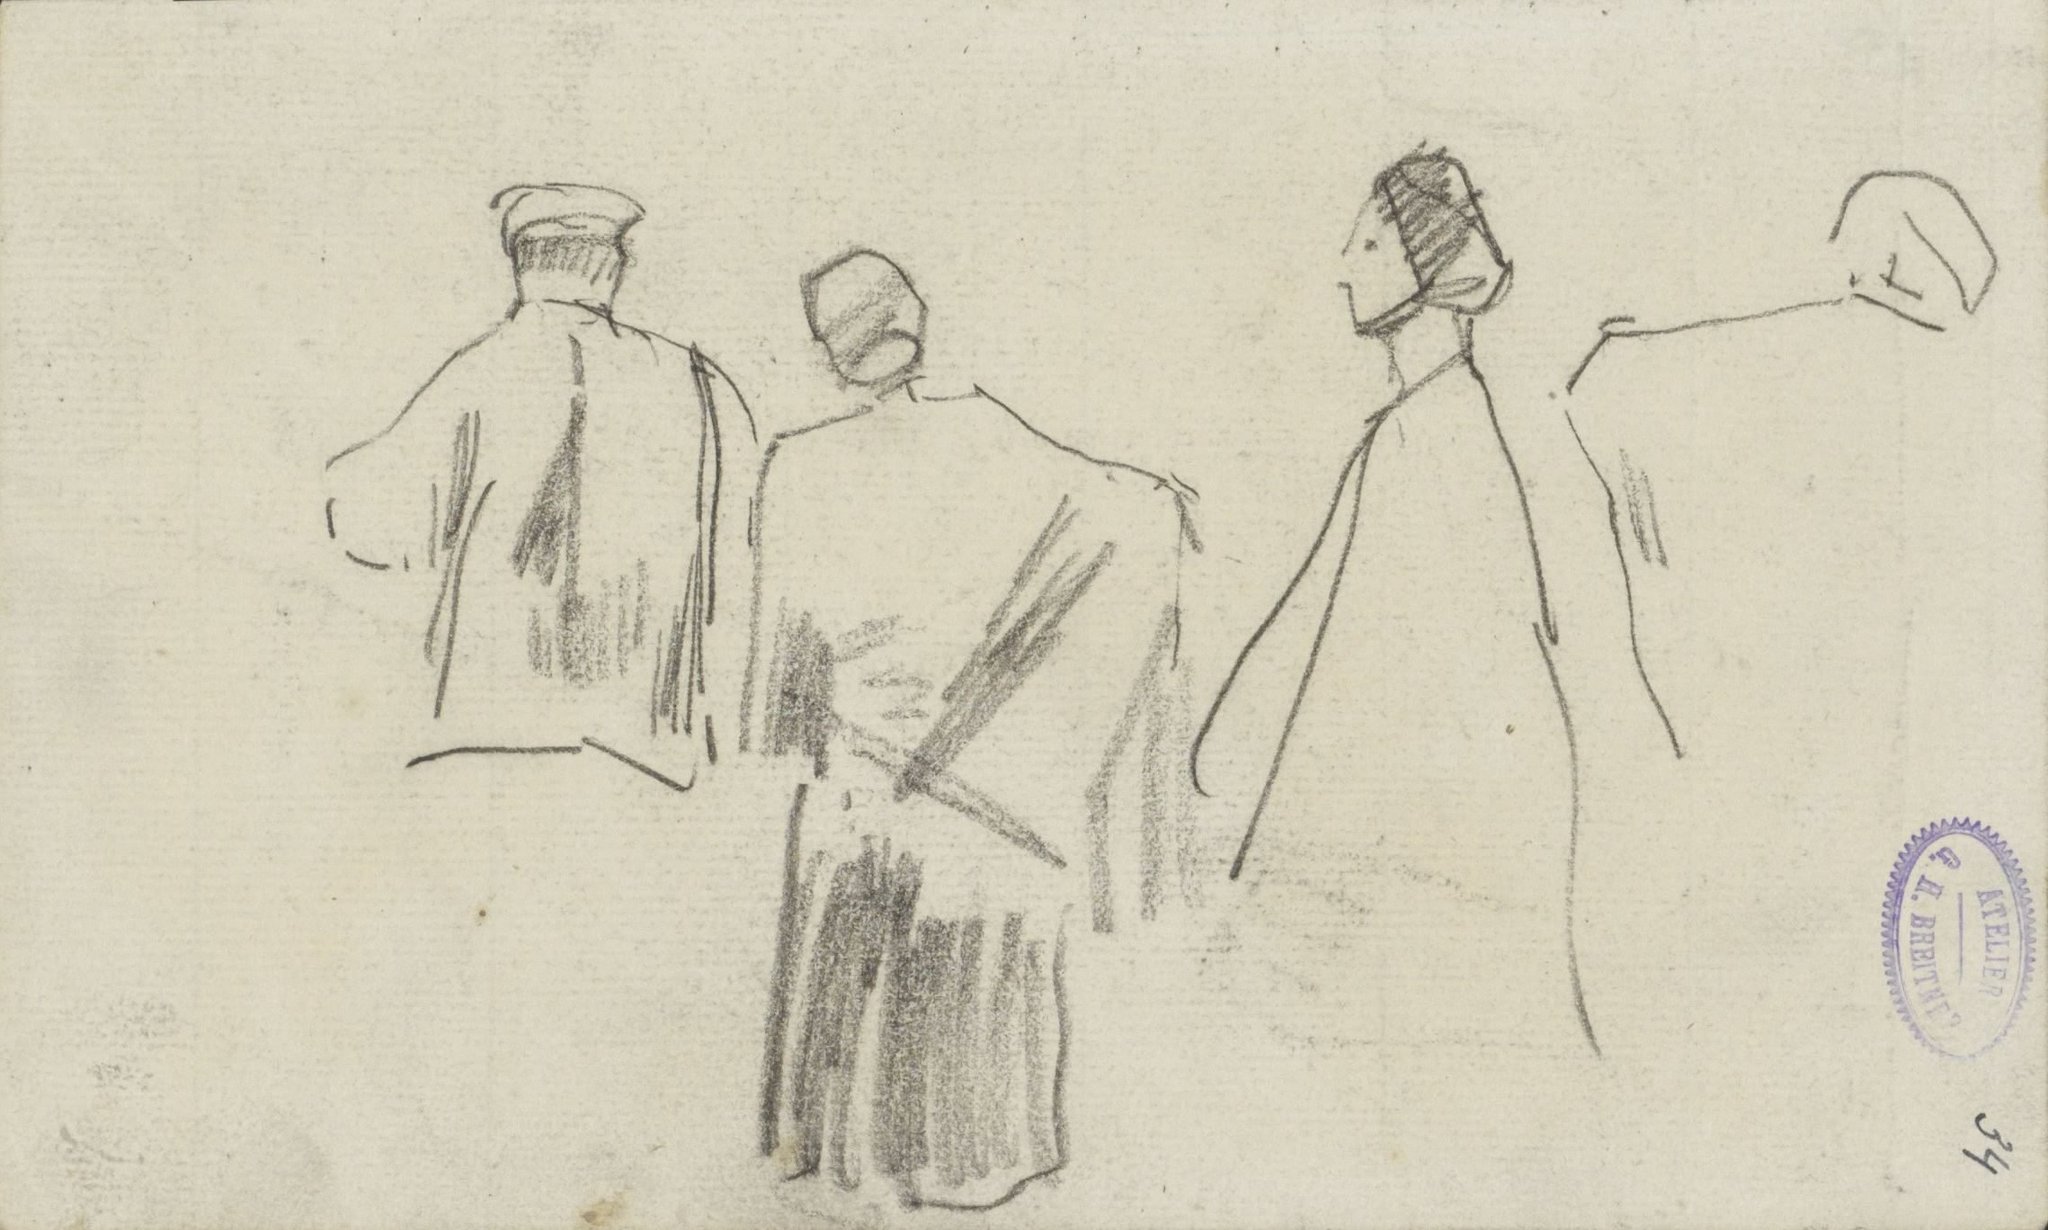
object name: drawing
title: Vier figuurstudies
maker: george hendrik breitner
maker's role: draughtsman, painter, print maker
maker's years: 1857-1923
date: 1880-1923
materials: chalk, paper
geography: netherlands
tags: standing figure - aa - female human figure (+ sideview, profile), standing figure - aa - female human figure (+ back view), standing figure (+ back view)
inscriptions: workshop stamp: Lugt 291d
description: Een man en een vrouw, op de rug gezien, en twee vrouwen in profiel.